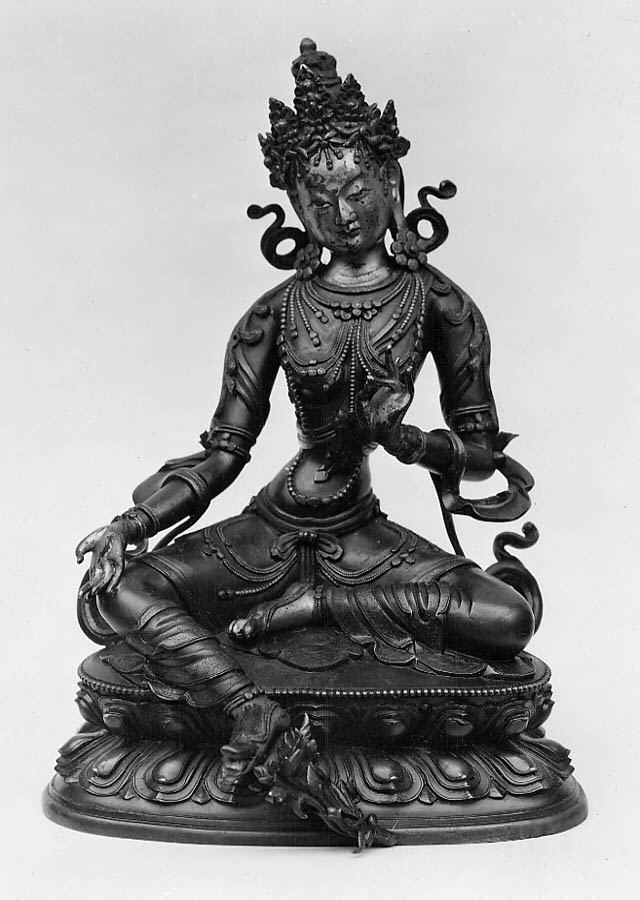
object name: figure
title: Seated Green Tara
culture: tibetan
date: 1601-1800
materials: bronze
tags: buddhism,deities